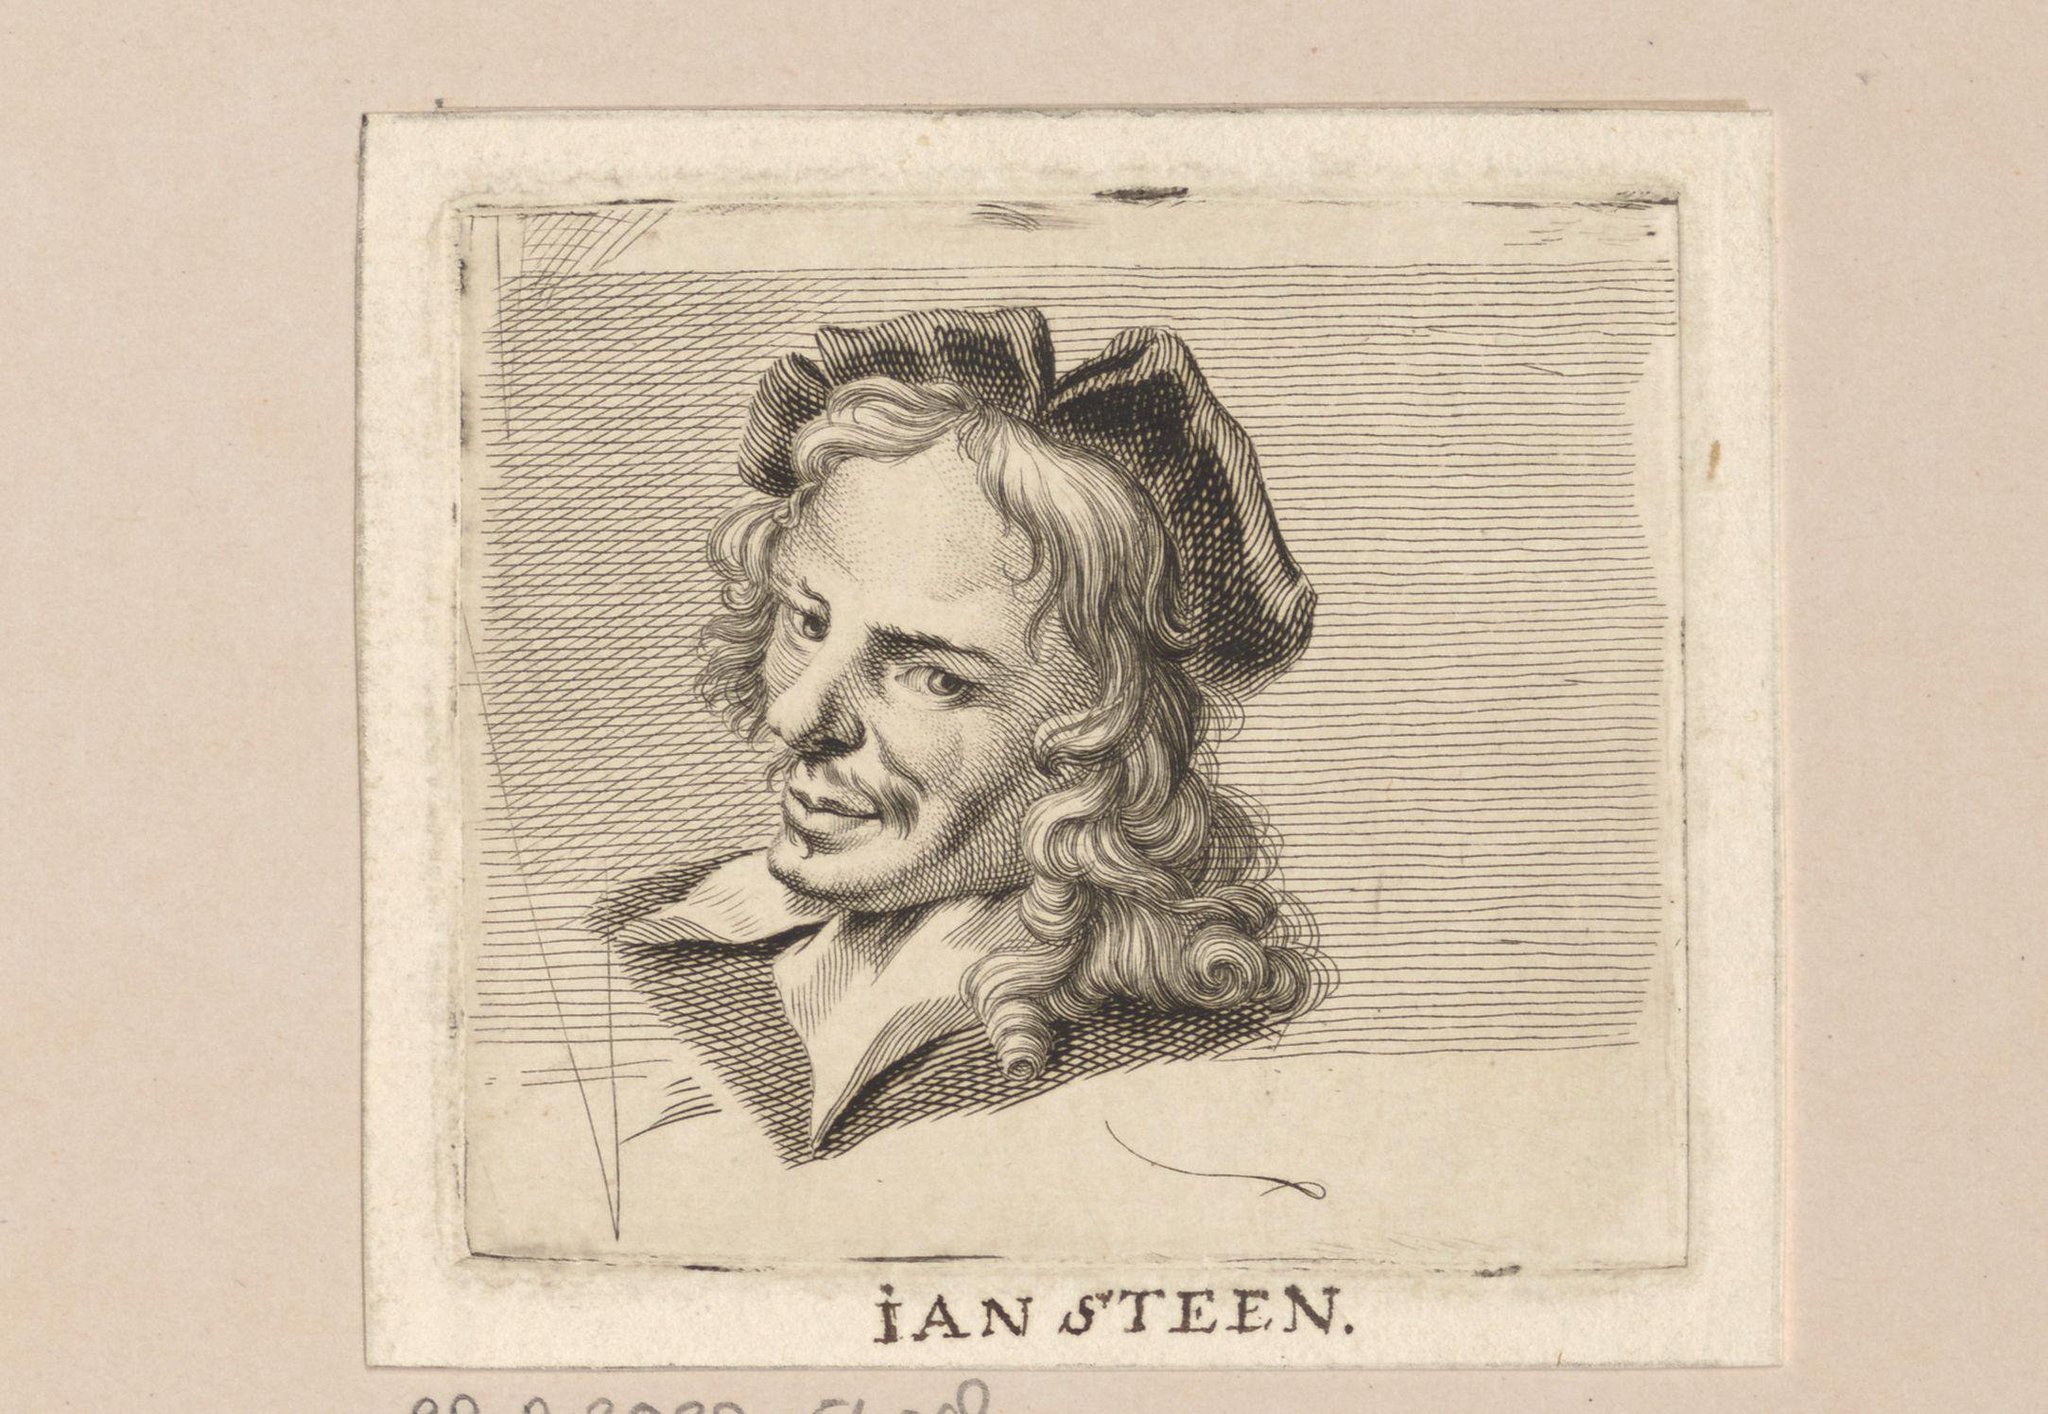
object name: print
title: Portret van Jan Havicksz. Steen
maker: Anonymous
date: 1700-1799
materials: paper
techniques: engraving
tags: leiden, painter, print maker, jan havicksz. steen, historical persons, portrait, self-portrait of artist